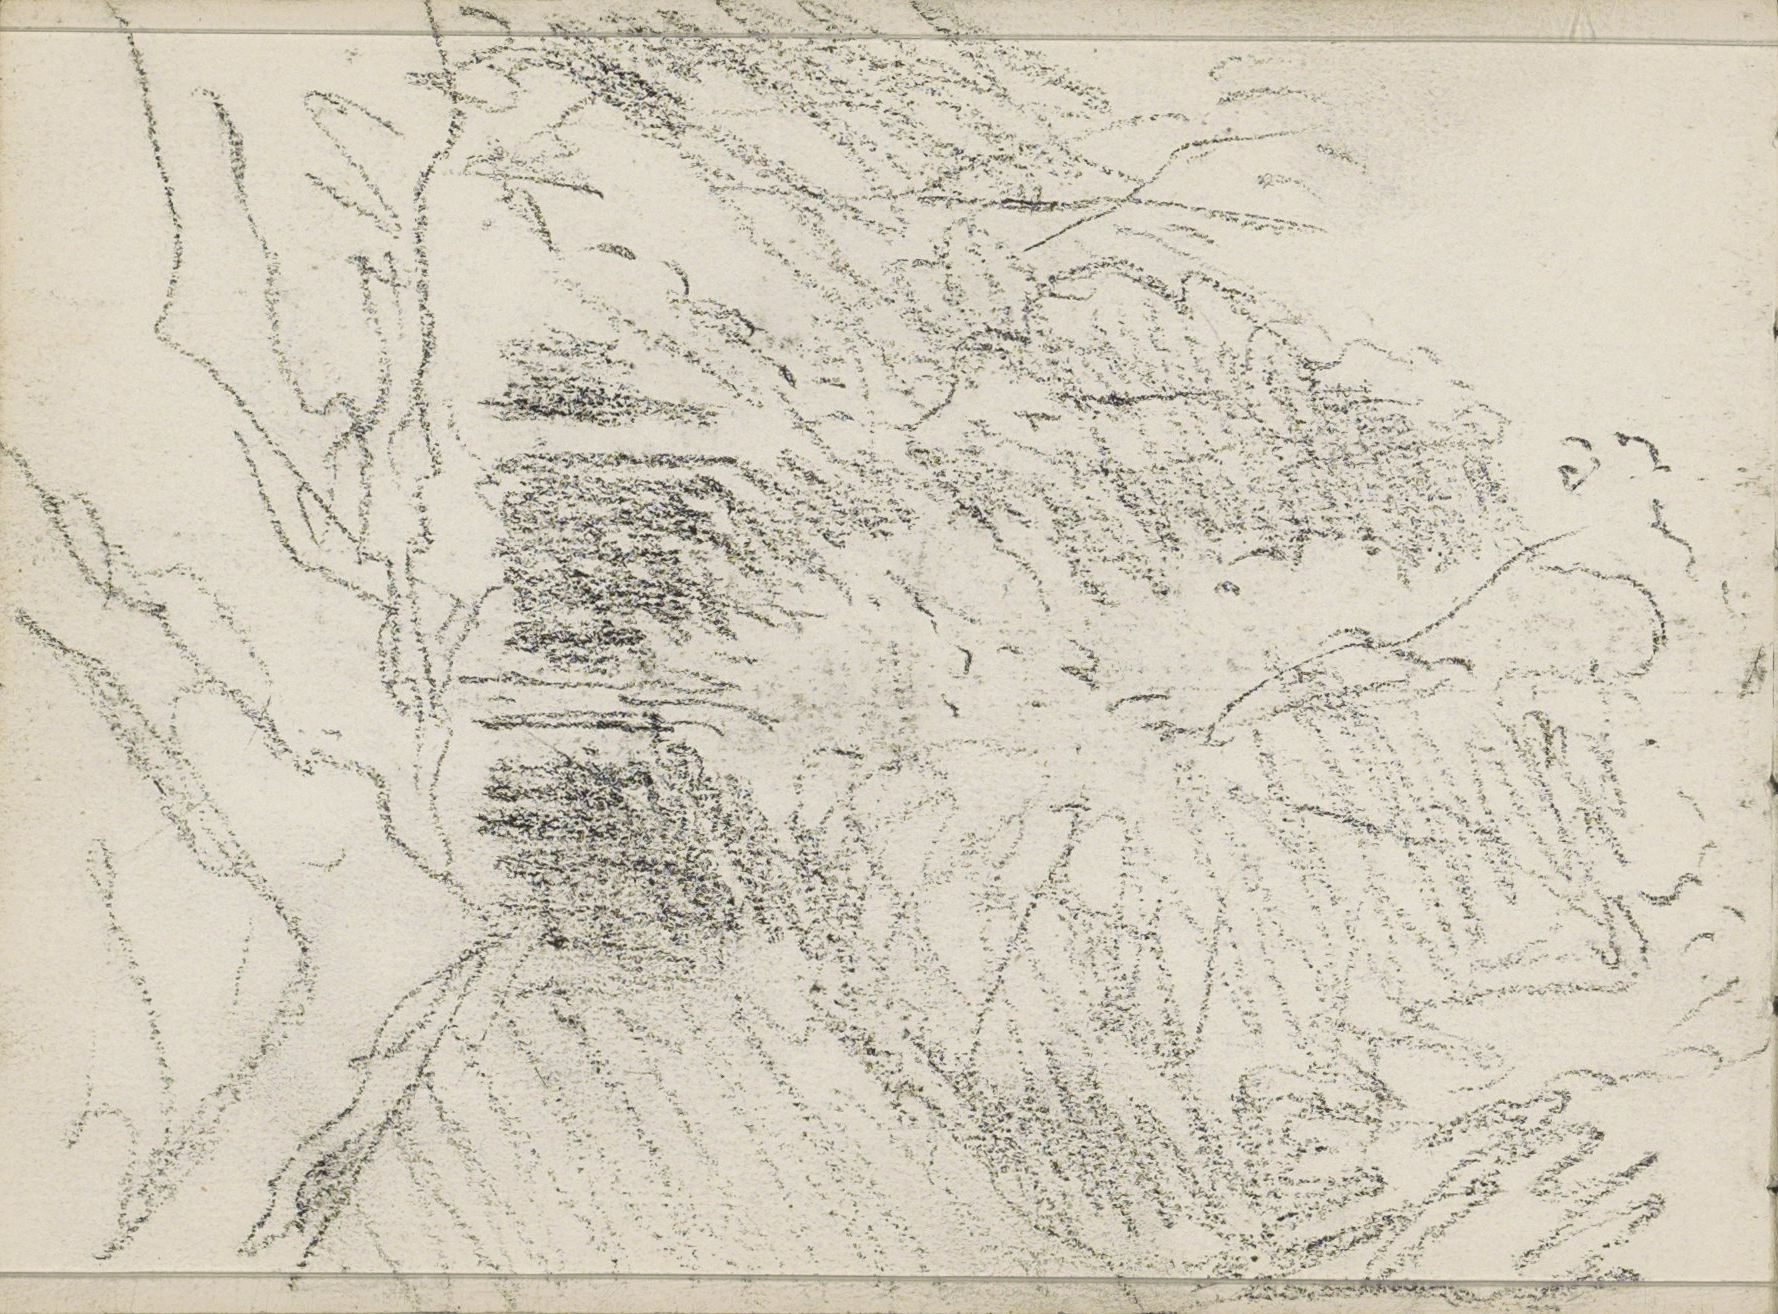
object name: sketchbook leaf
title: Bosrand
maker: anton mauve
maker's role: draughtsman, painter, print maker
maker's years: 1838-1888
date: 1848-1888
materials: chalk, paper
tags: forest, wood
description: Blad 10 verso uit een schetsboek met 33 bladen.